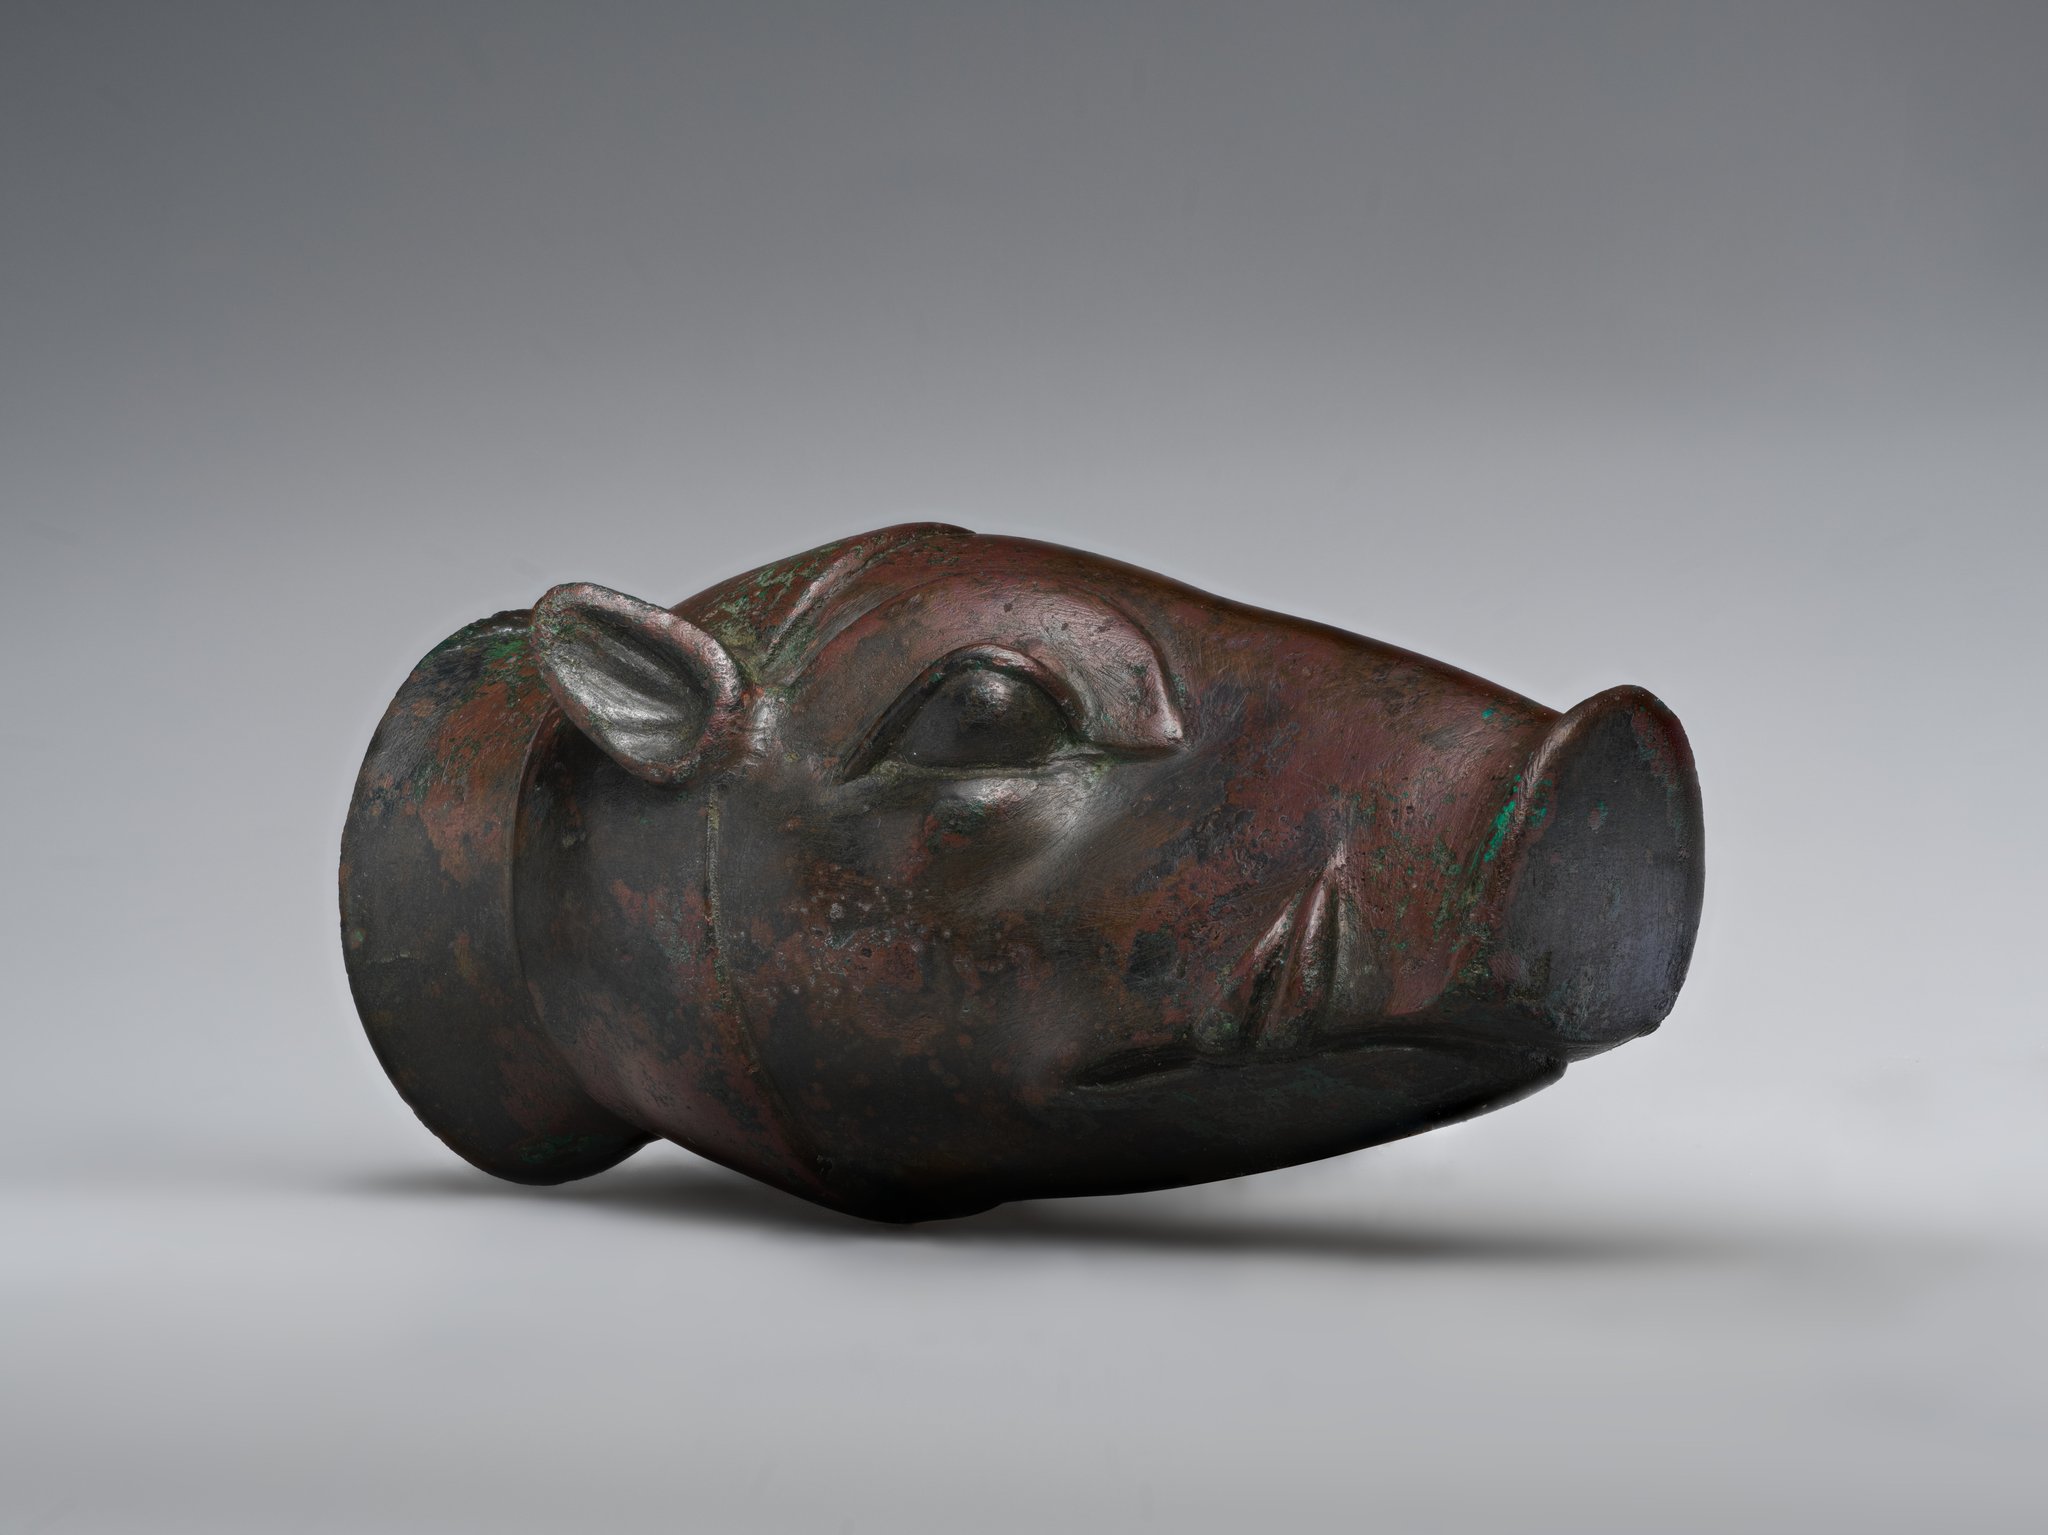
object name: vessel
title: Vessel in form of boar's head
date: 600-301 BCE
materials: bronze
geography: iran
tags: boars